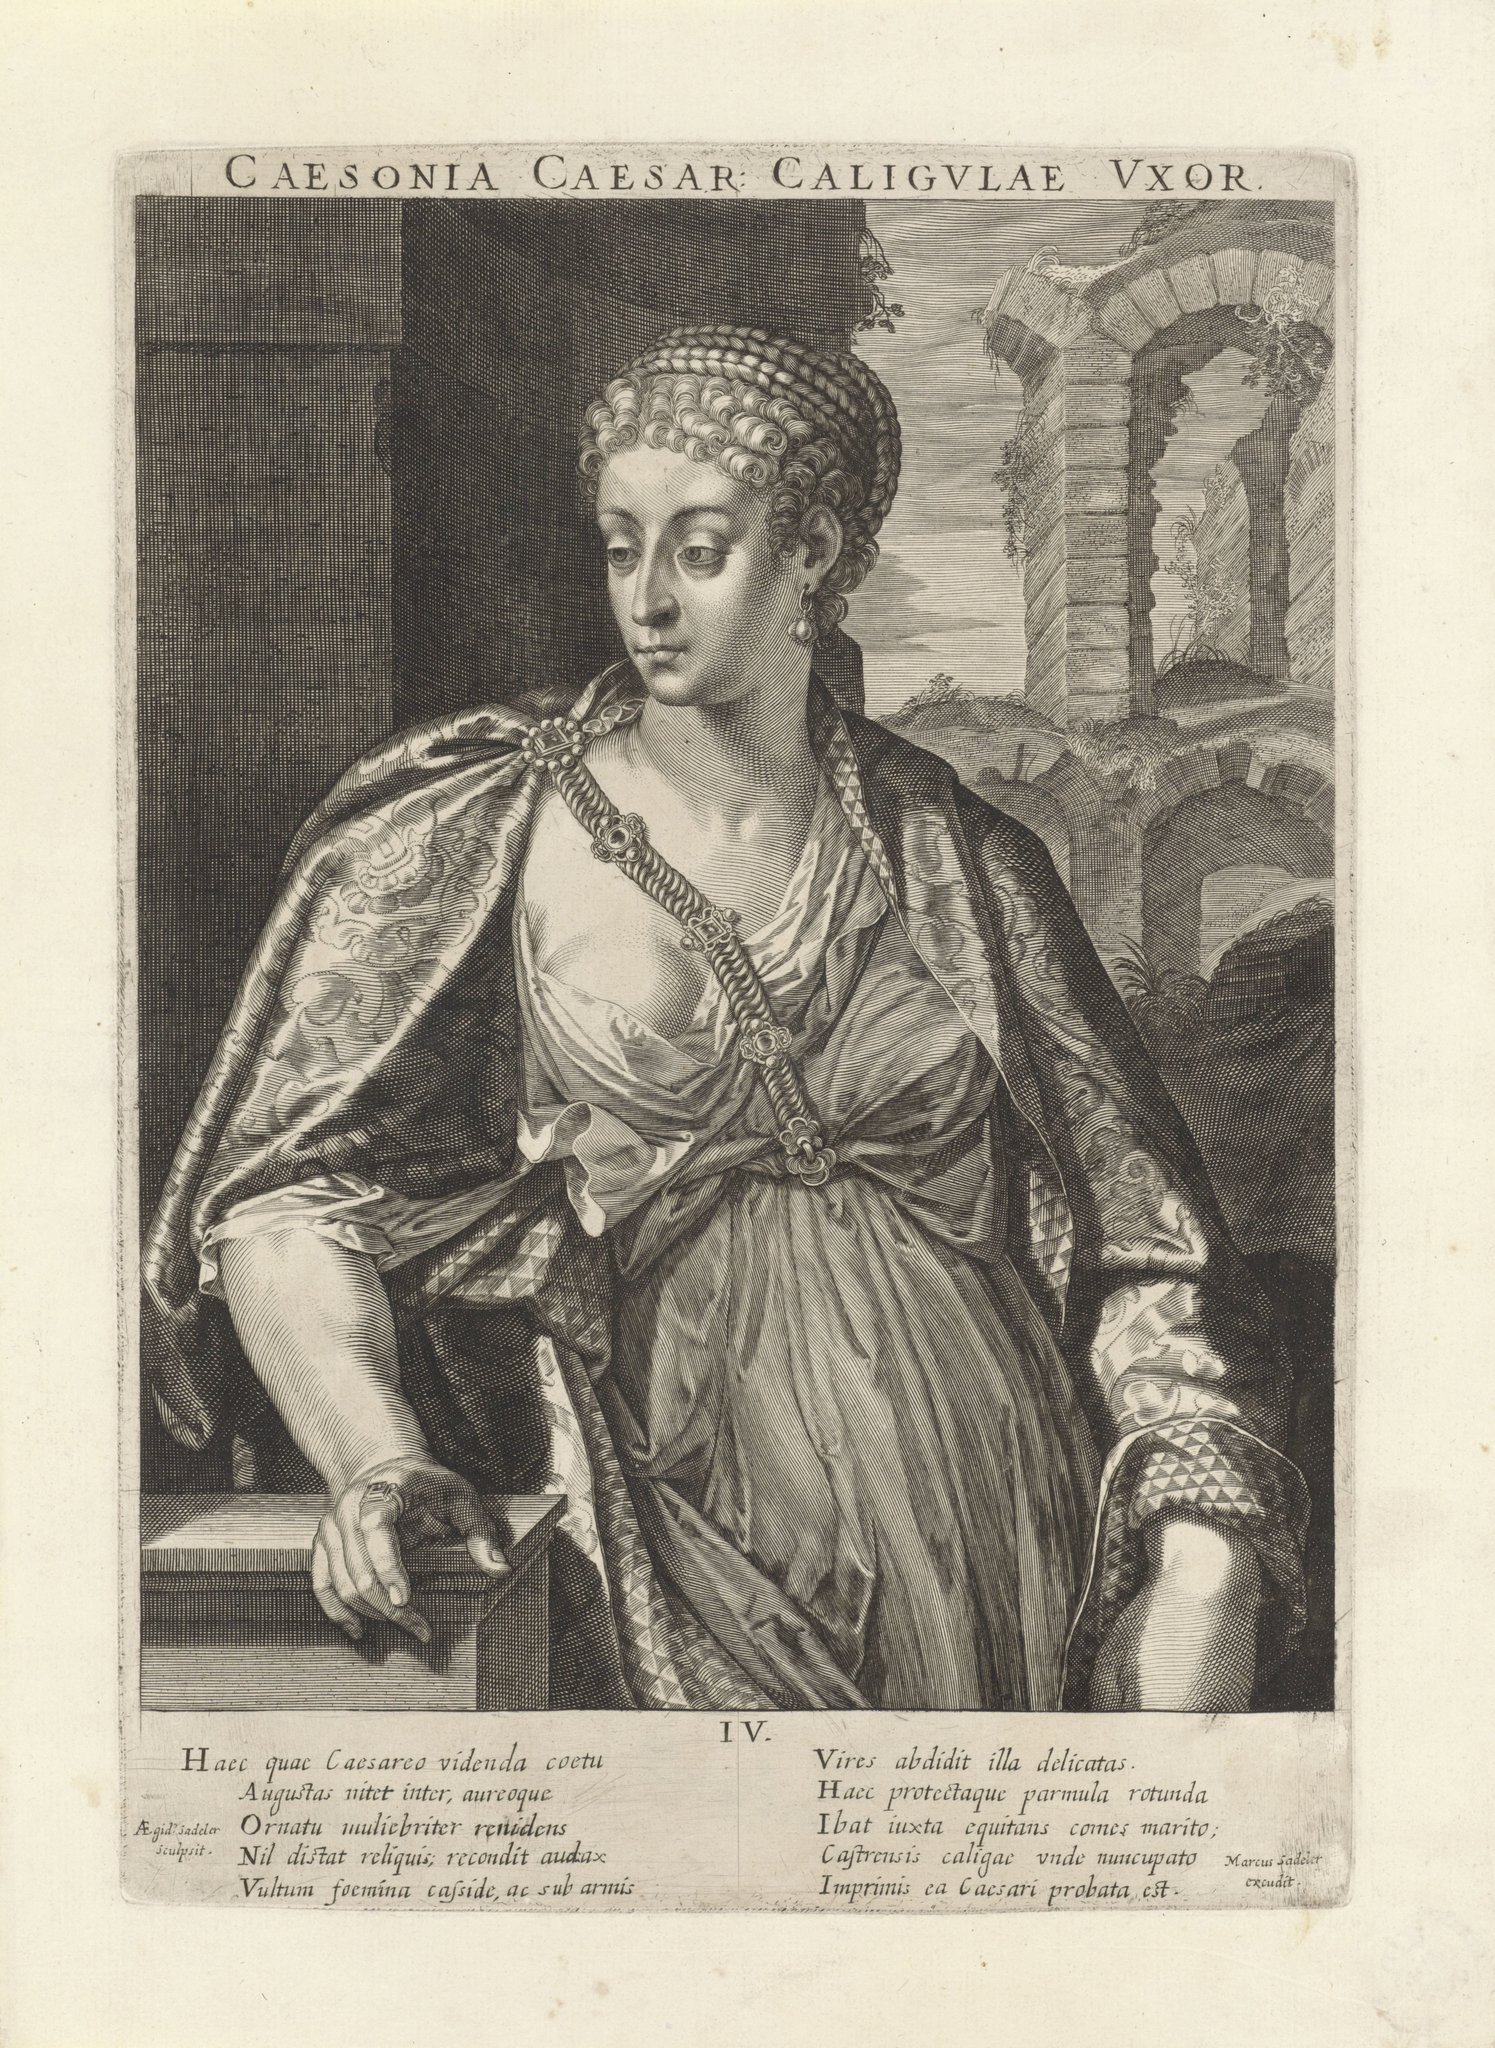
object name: print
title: Beroemde Romeinse vrouwen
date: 1597-1629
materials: paper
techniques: engraving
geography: venice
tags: caesonia milonia (romeins keizerin)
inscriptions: collector's mark: Lugt 240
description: Milonia Caesonia , vierde vrouw van keizer Caligula